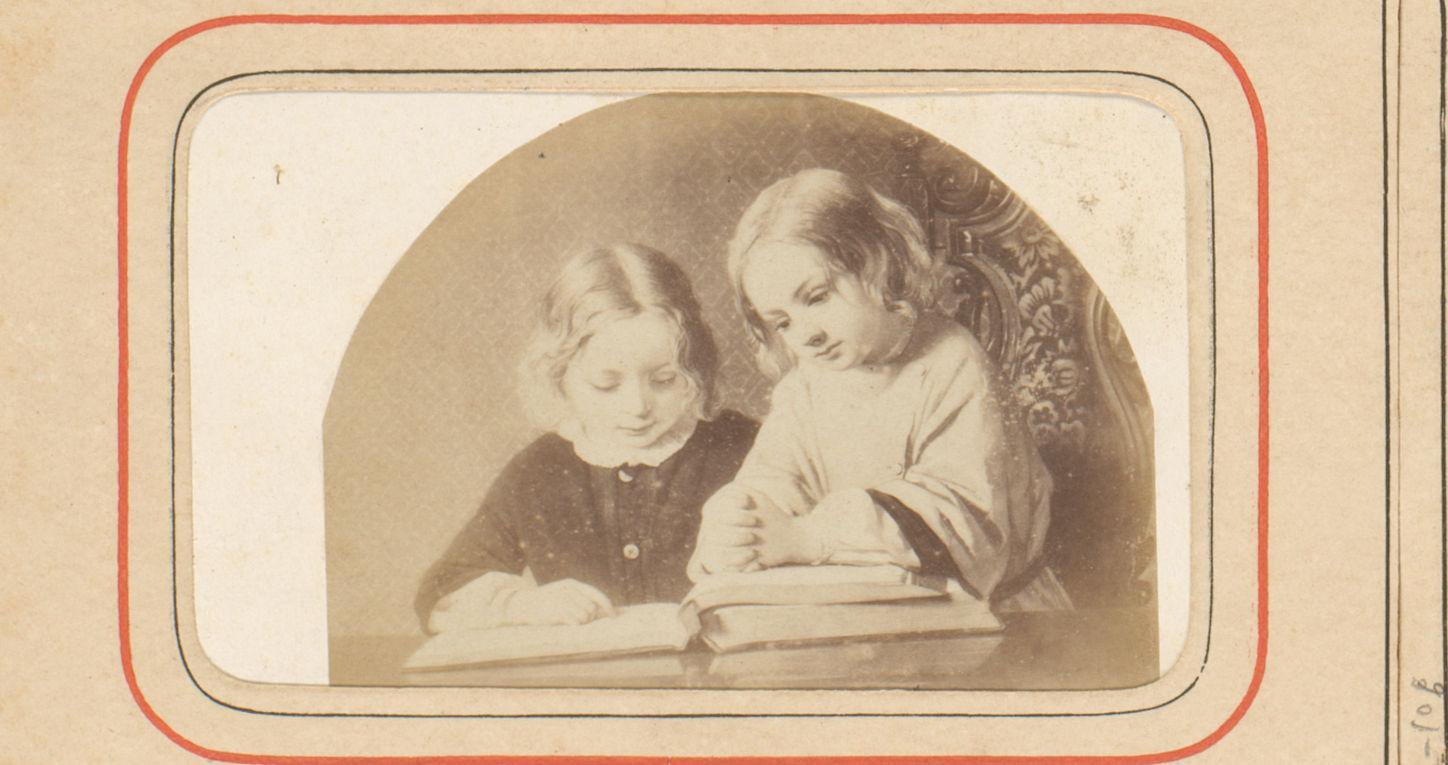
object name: reproduction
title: Fotoreproductie van een schilderij van twee kinderen met een Bijbel, met gedicht door J.J.L. ten Kate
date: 1870-1890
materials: cardboard, paper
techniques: albumen print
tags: reading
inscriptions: inscription: ‘Vriendelijke kinderoogen,/ Rein of ge in den Hemel ziet,/ Over 't Bijbelblad gebogen, -/ Zoeter schouwspel is er niet! (...)’